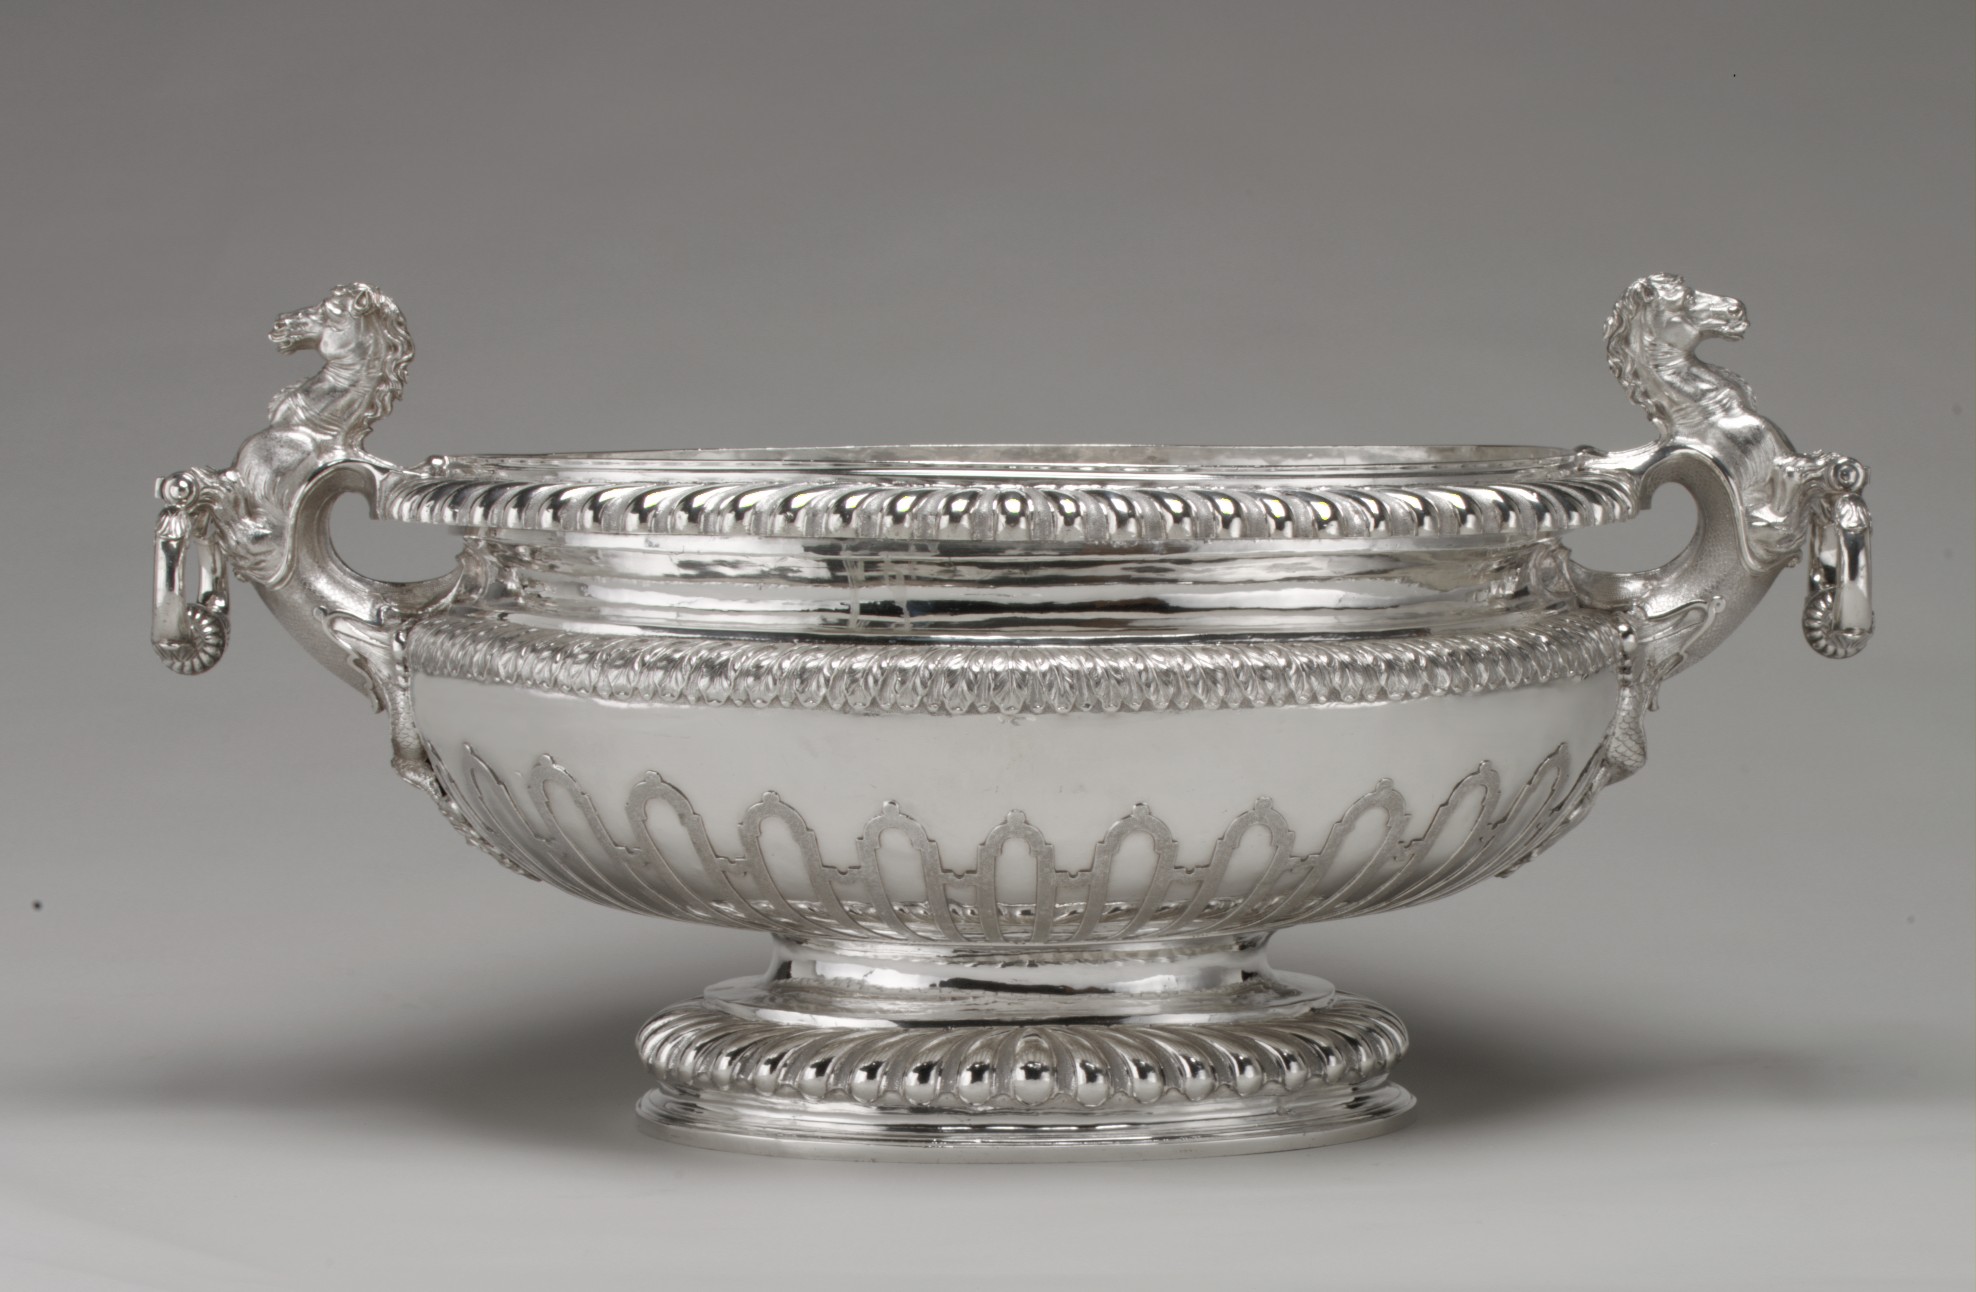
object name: wine cistern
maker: lewis mettayer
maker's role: maker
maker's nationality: british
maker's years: 1640-1740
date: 1709-1710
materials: silver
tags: horses